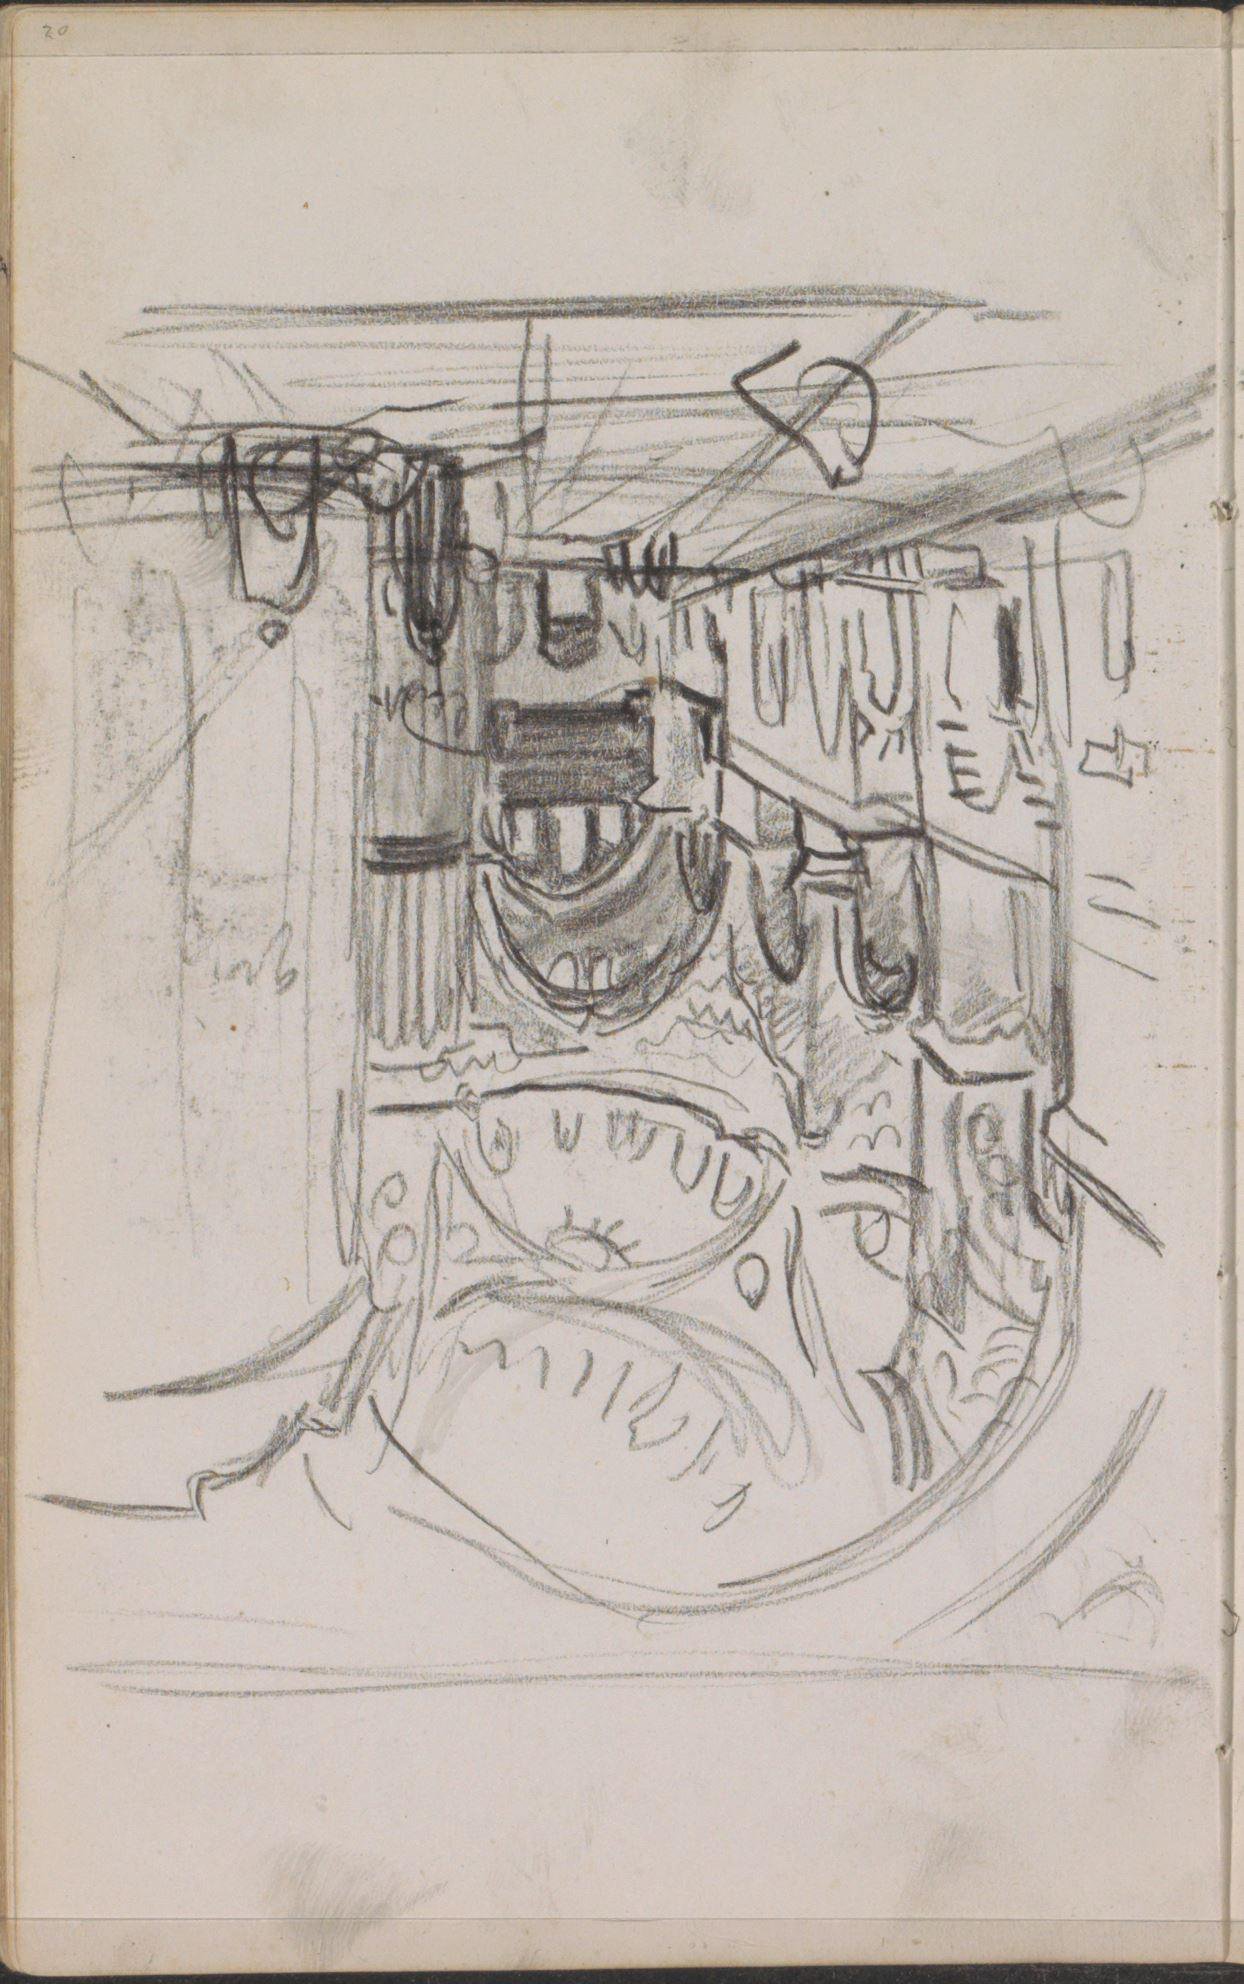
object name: sketchbook leaf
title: Interieur van een moskee met figuren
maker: marius bauer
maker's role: draughtsman, print maker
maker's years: 1867-1932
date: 1896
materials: chalk, paper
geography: istanbul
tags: standing figure, temple, shrine ~ islam, mohammedanism, dome ~ architecture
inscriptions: kleurnotitie, handgeschreven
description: Bauer bewerkte de schets voor een verslag van zijn reis naar Constantinopel voor het tijdschrift De Kroniek in 1896 (zie documentatie).